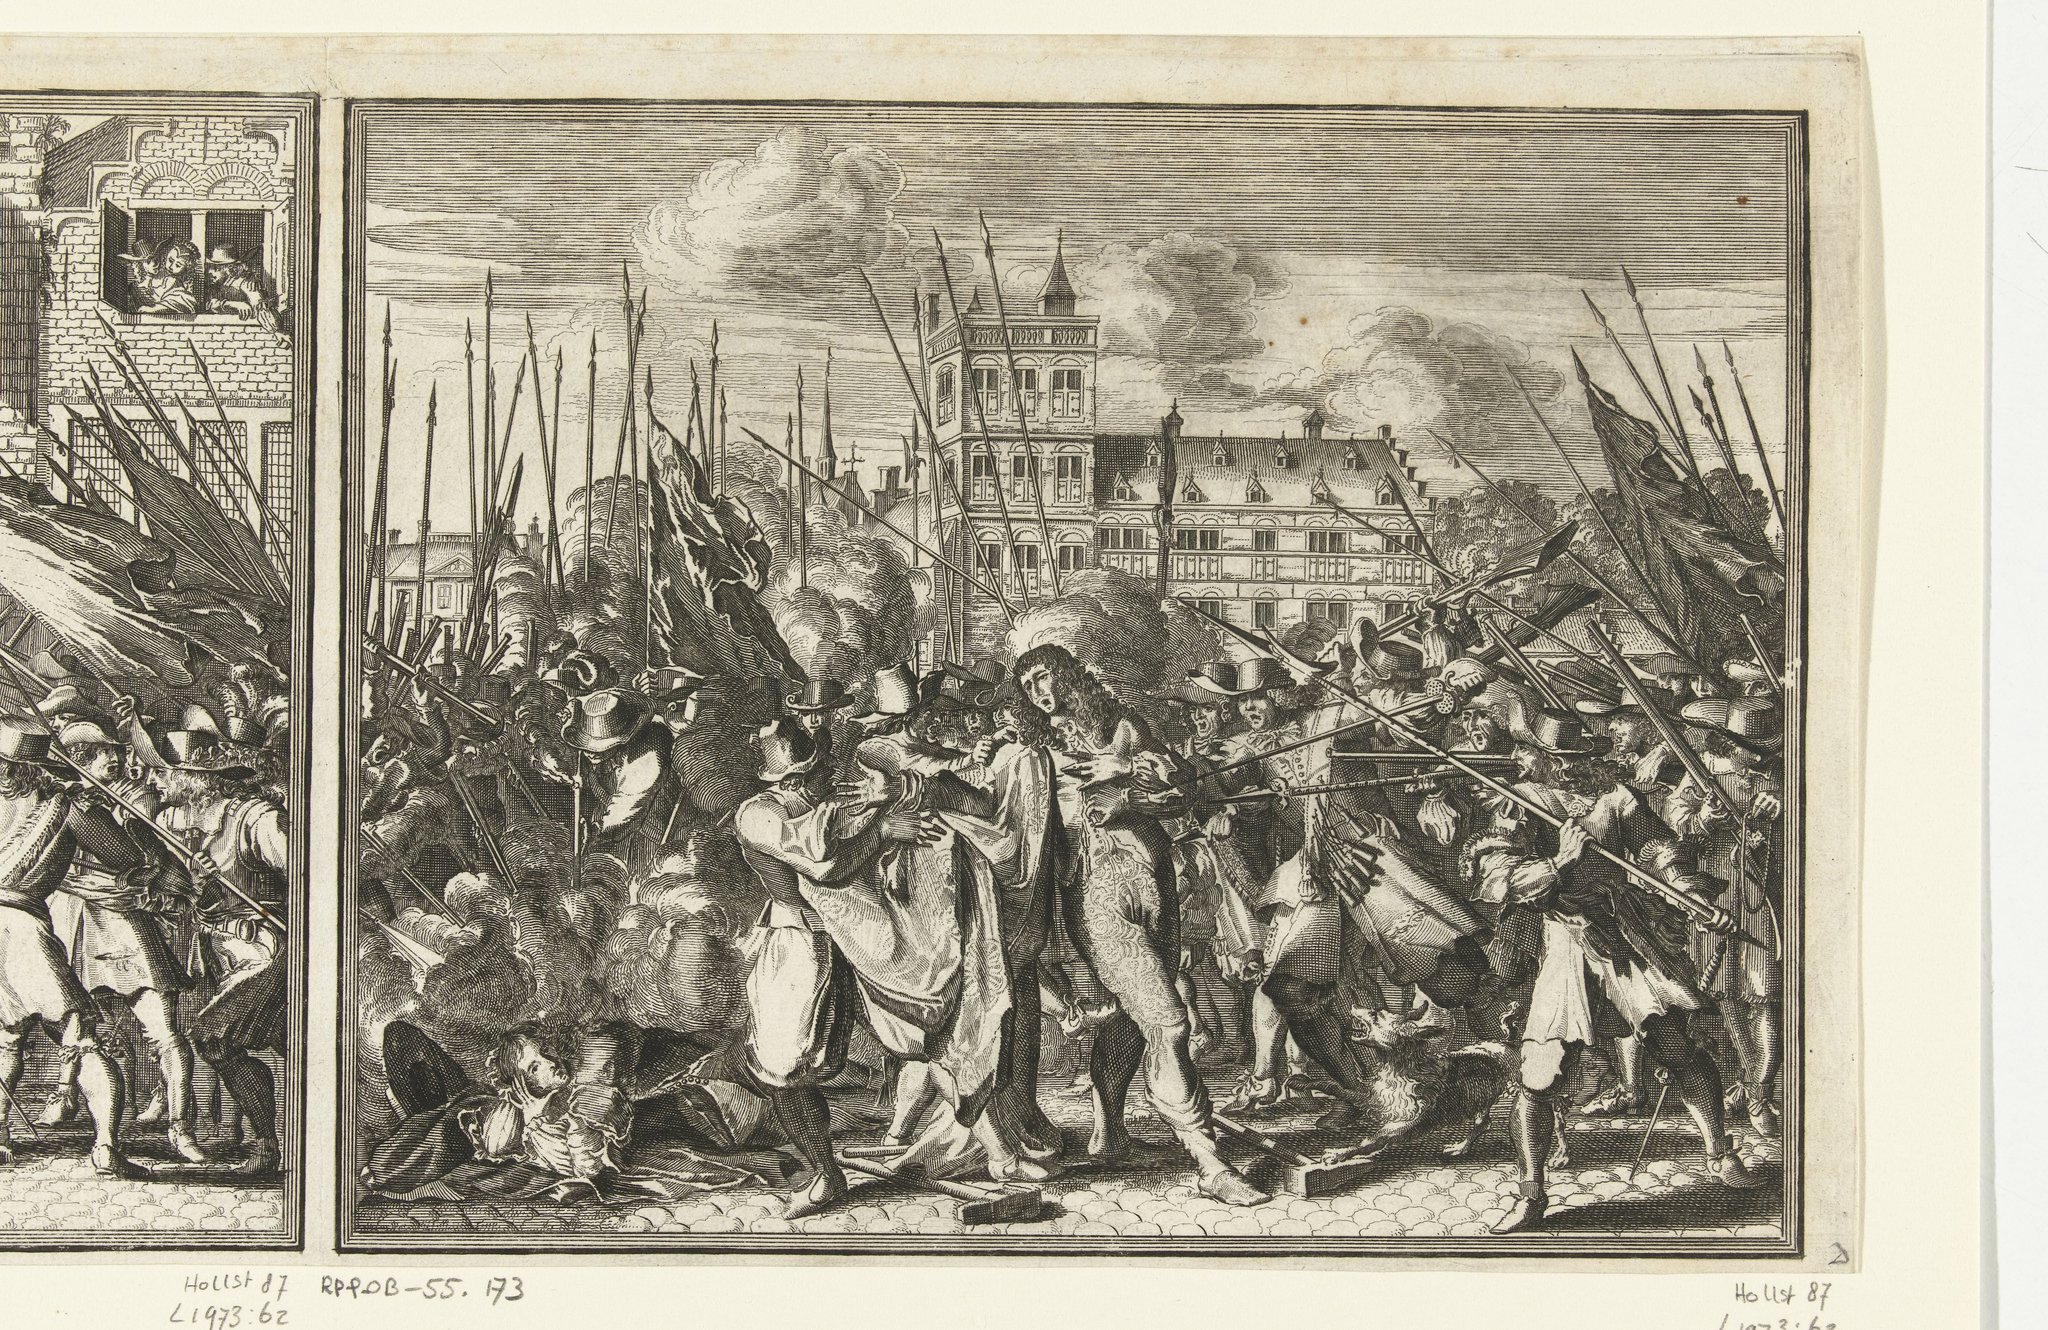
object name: print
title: Aanval op Cornelis de Witt, 1672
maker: Anonymous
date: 1672-1699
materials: paper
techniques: engraving, etching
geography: netherlands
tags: johan de witt, the (nude) human figure; 'corpo humano' (ripa) (+ attacking somebody), the hague, rampjaar (disaster year)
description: Cornelis de Witt, 1672. Hij wordt van alle kanten belaagd. Johan de Witt is links op de grond gevallen.